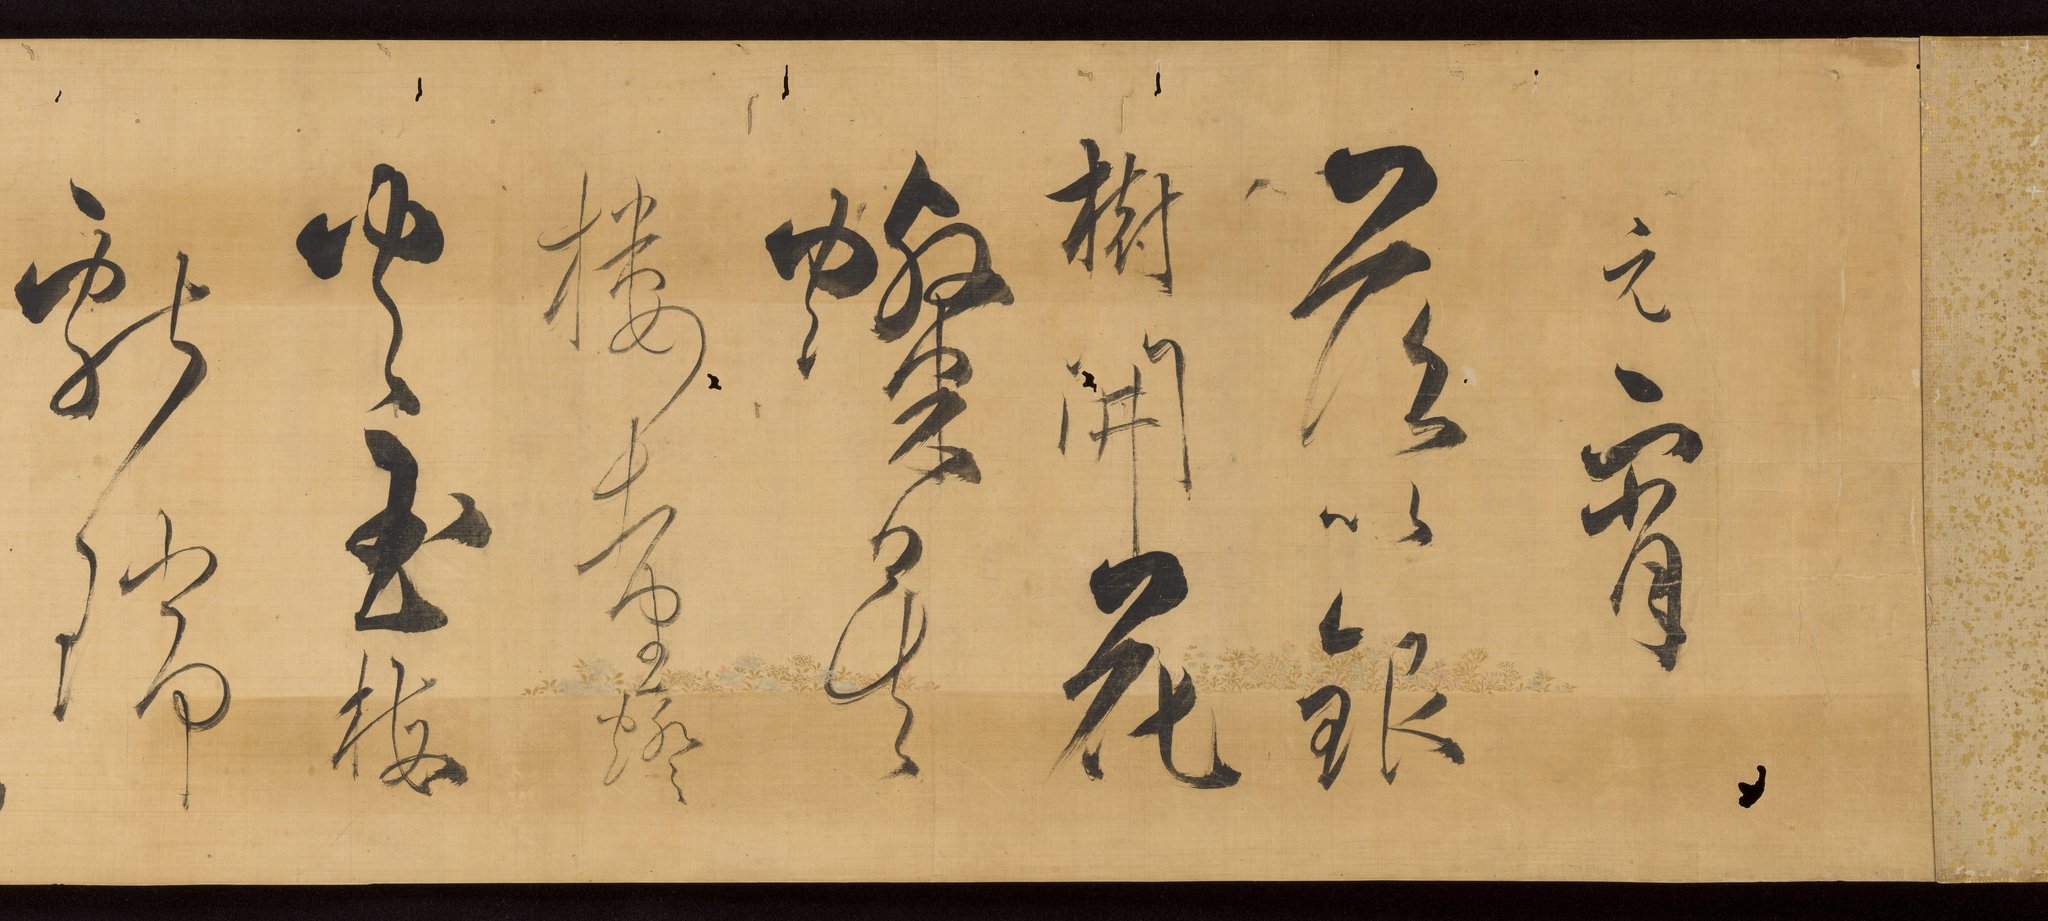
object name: handscroll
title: Two Sample Letters on the Chinese Lantern Festival and a Poem about Plum Blossoms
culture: japanese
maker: kojima sōshin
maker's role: artist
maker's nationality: japanese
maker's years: 1580-1656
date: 1657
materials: ink, paper